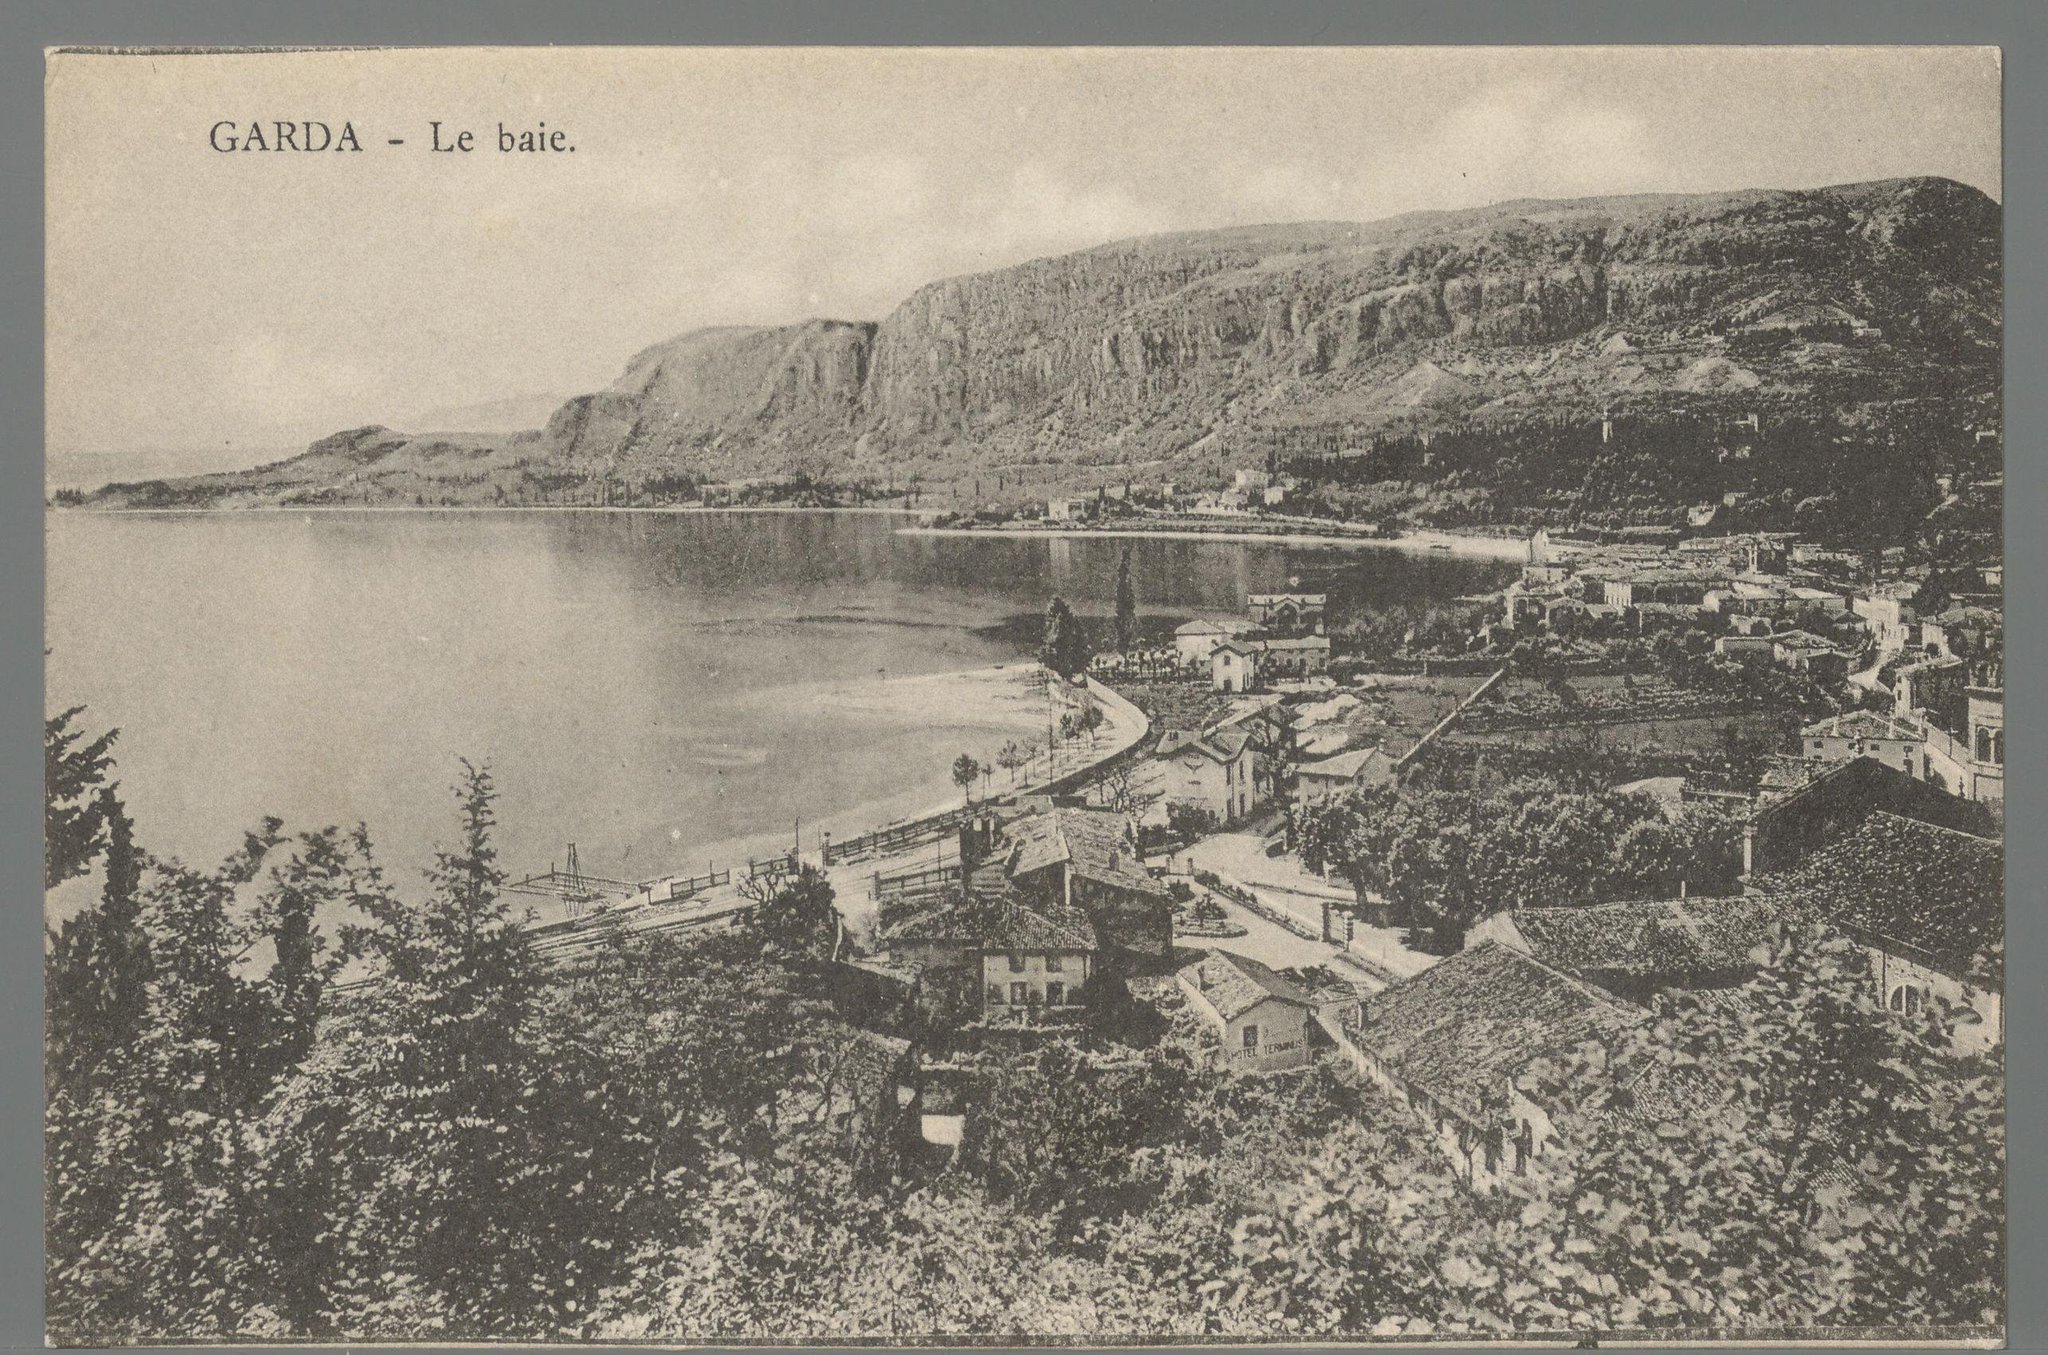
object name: ansichtkaart, prentbriefkaart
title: Garda. Le baie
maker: Anonymous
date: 1906-1930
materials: cardboard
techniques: photograph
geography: salò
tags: prospect of village, silhouette of village, lake, mountains